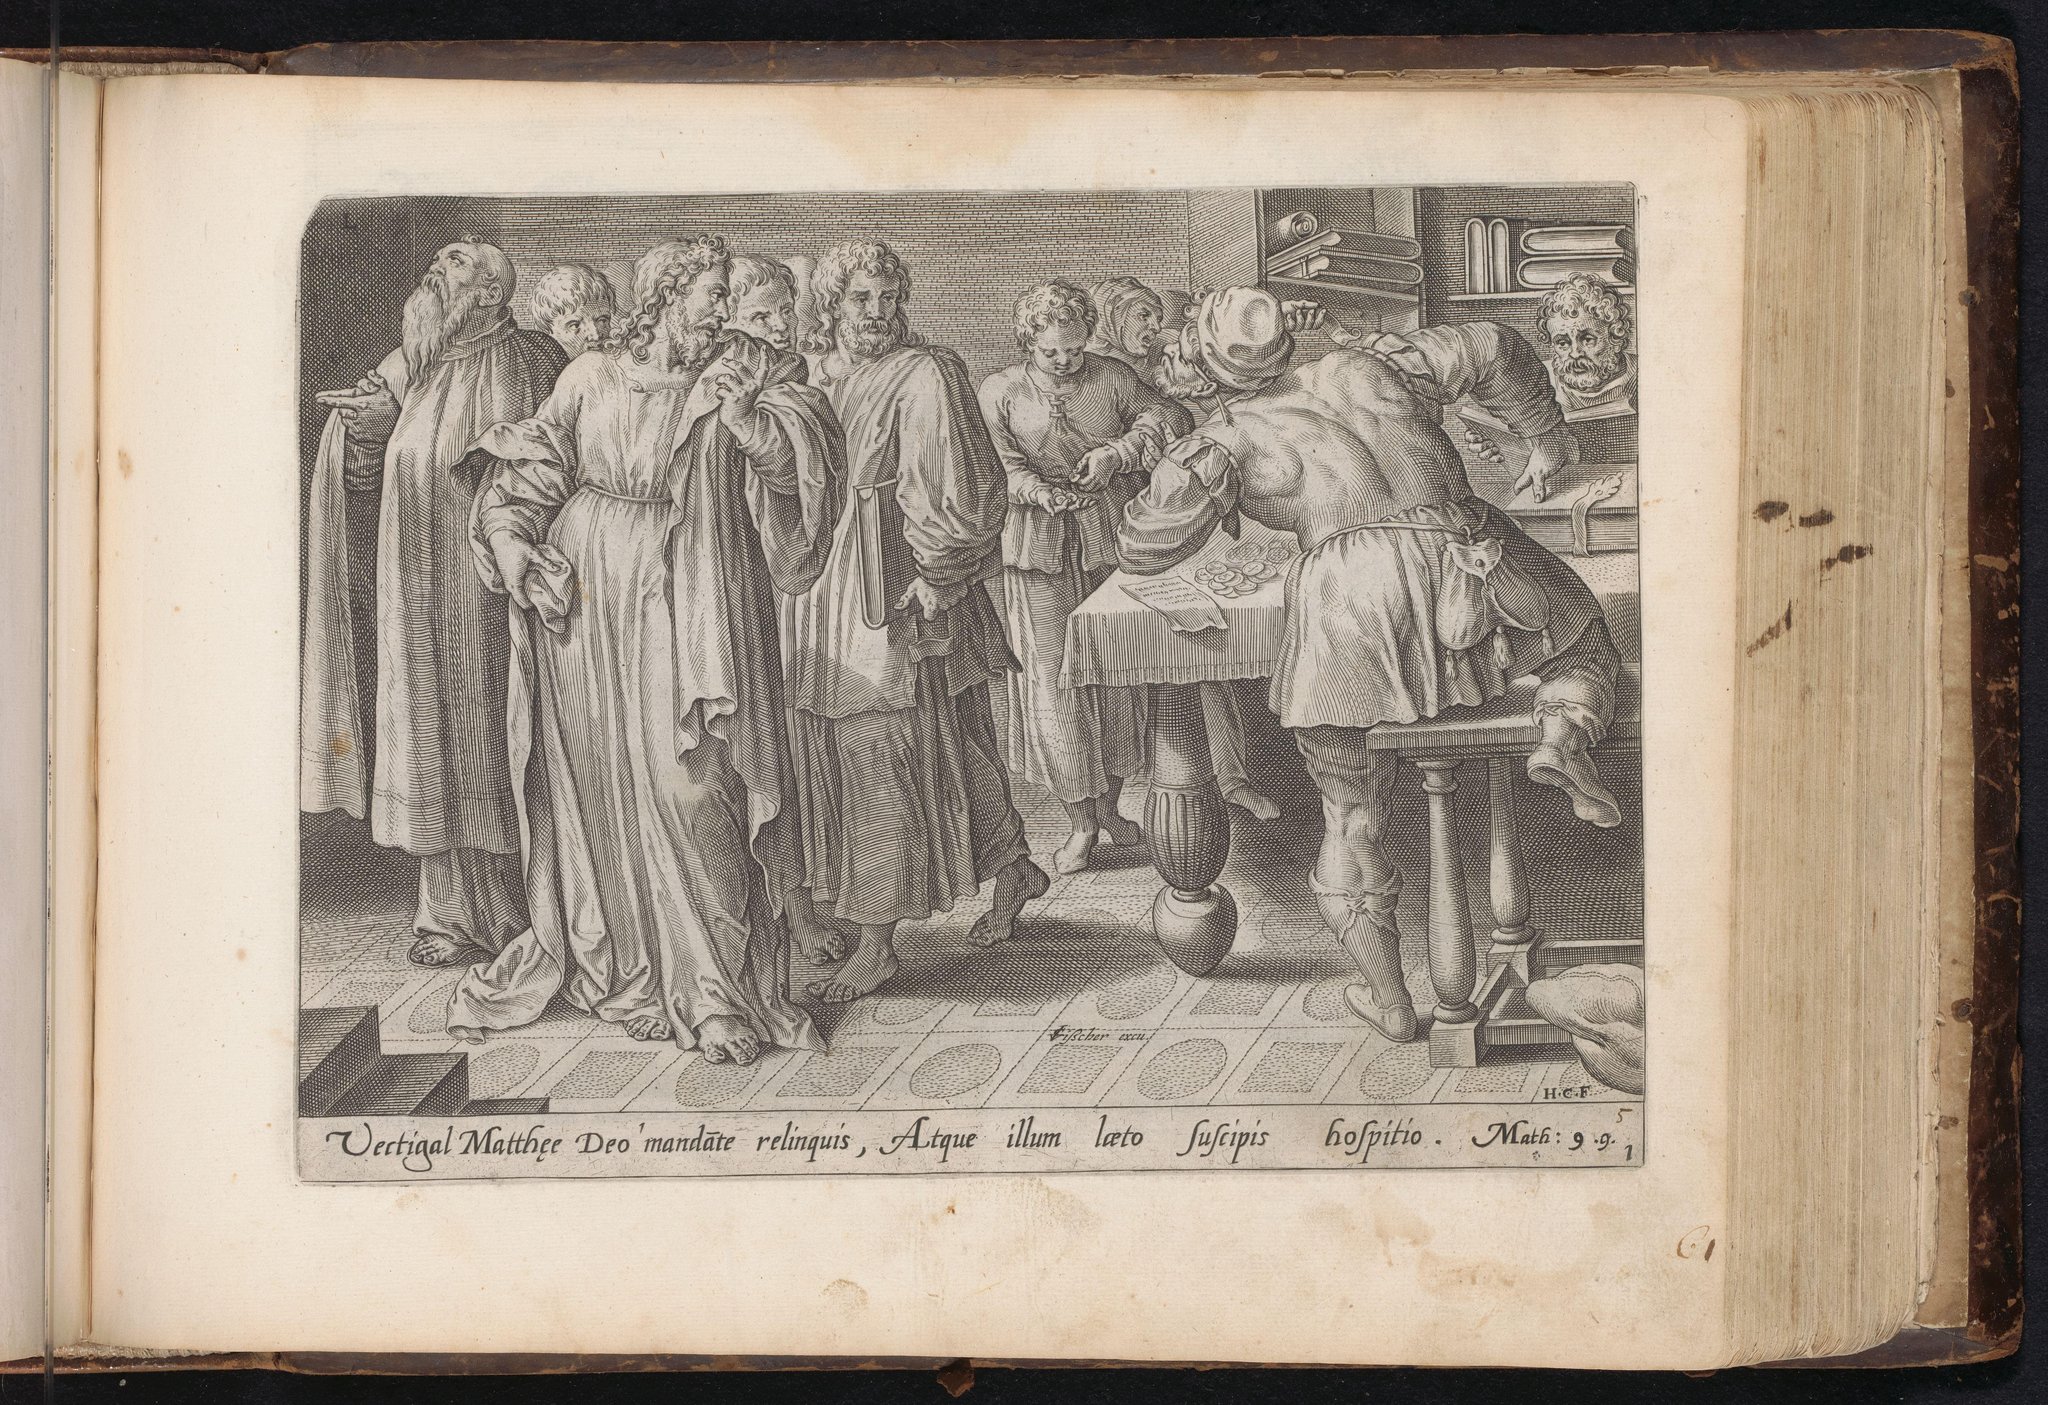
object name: print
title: Vastmakingh der Leere door Mirakelen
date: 1585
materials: paper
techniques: engraving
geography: alkmaar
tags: calling of matthew (levi), the tax-collector (usually with money lying on the table and people paying taxes) (matthew 9:9; mark 2:14; luke 5:27-28)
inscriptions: serial number: ‘5’, number: ‘61’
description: Christus passeert met zijn leerlingen de tollenaar Matteüs en vraagt hem hem te volgen. Matteüs staat op van zijn bank en verlaat de tafel waar hij belasting int. Onder de voorstelling een verwijzing in het Latijn naar de Bijbeltekst in Mat. 9:9. Deze prent maakt deel uit van een album.